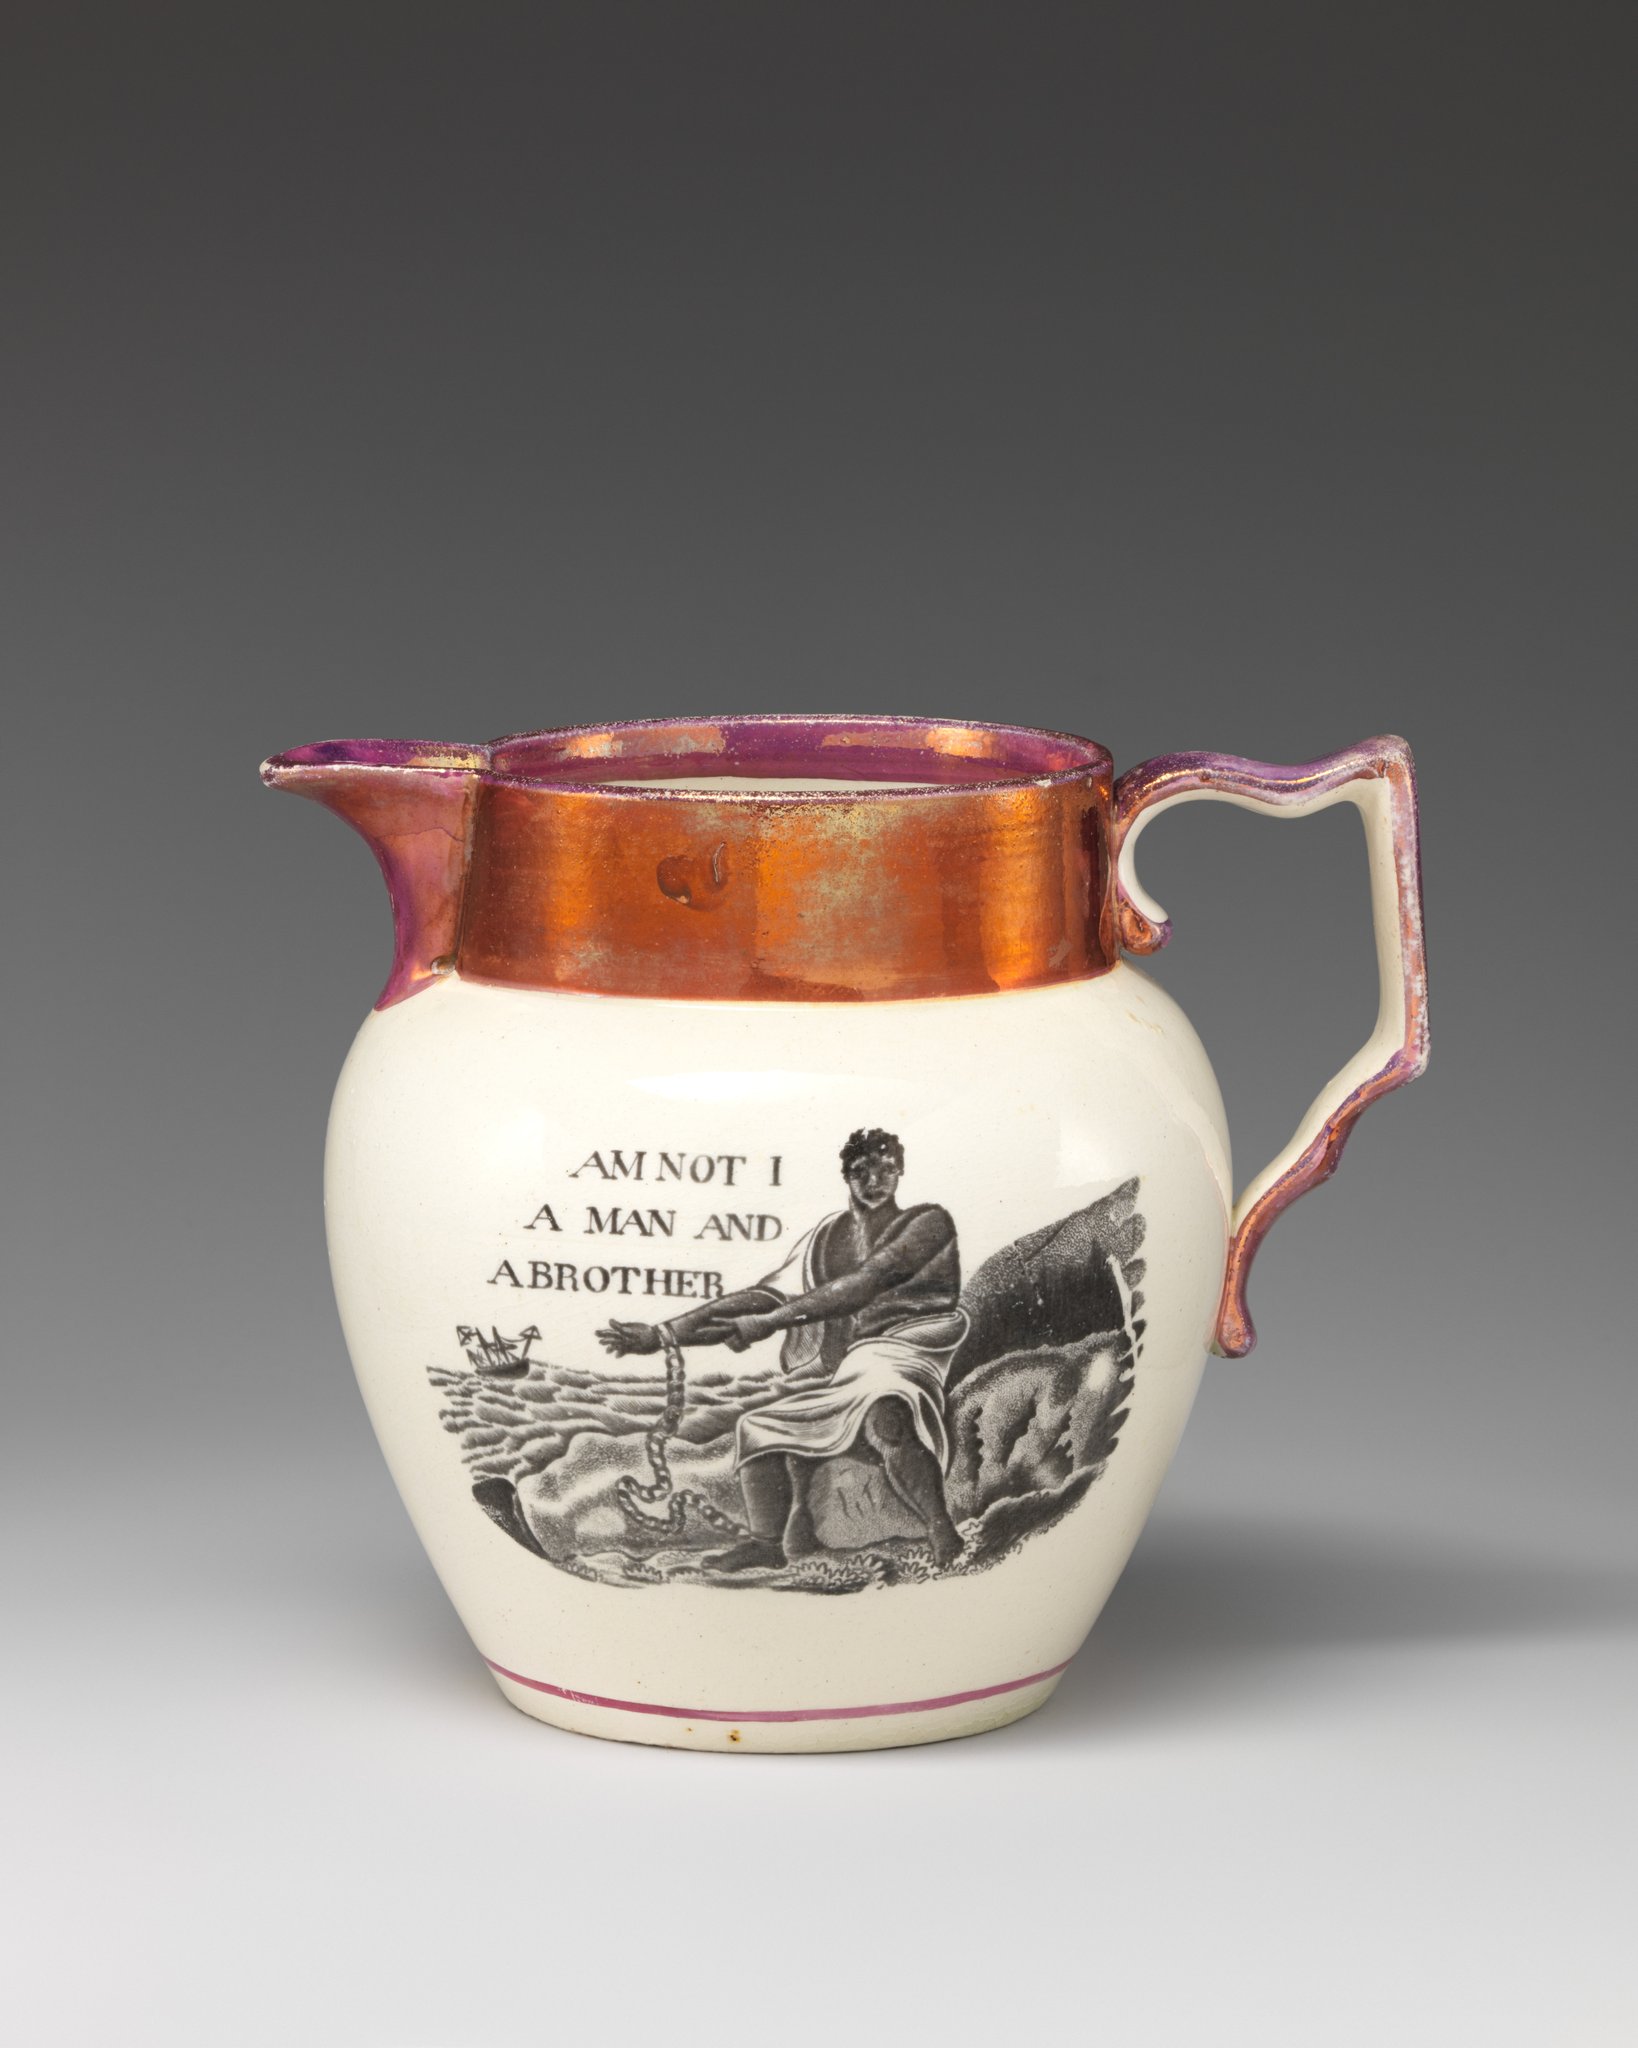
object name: jug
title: Abolitionist Jug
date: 1820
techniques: glazing, transfer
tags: slavery